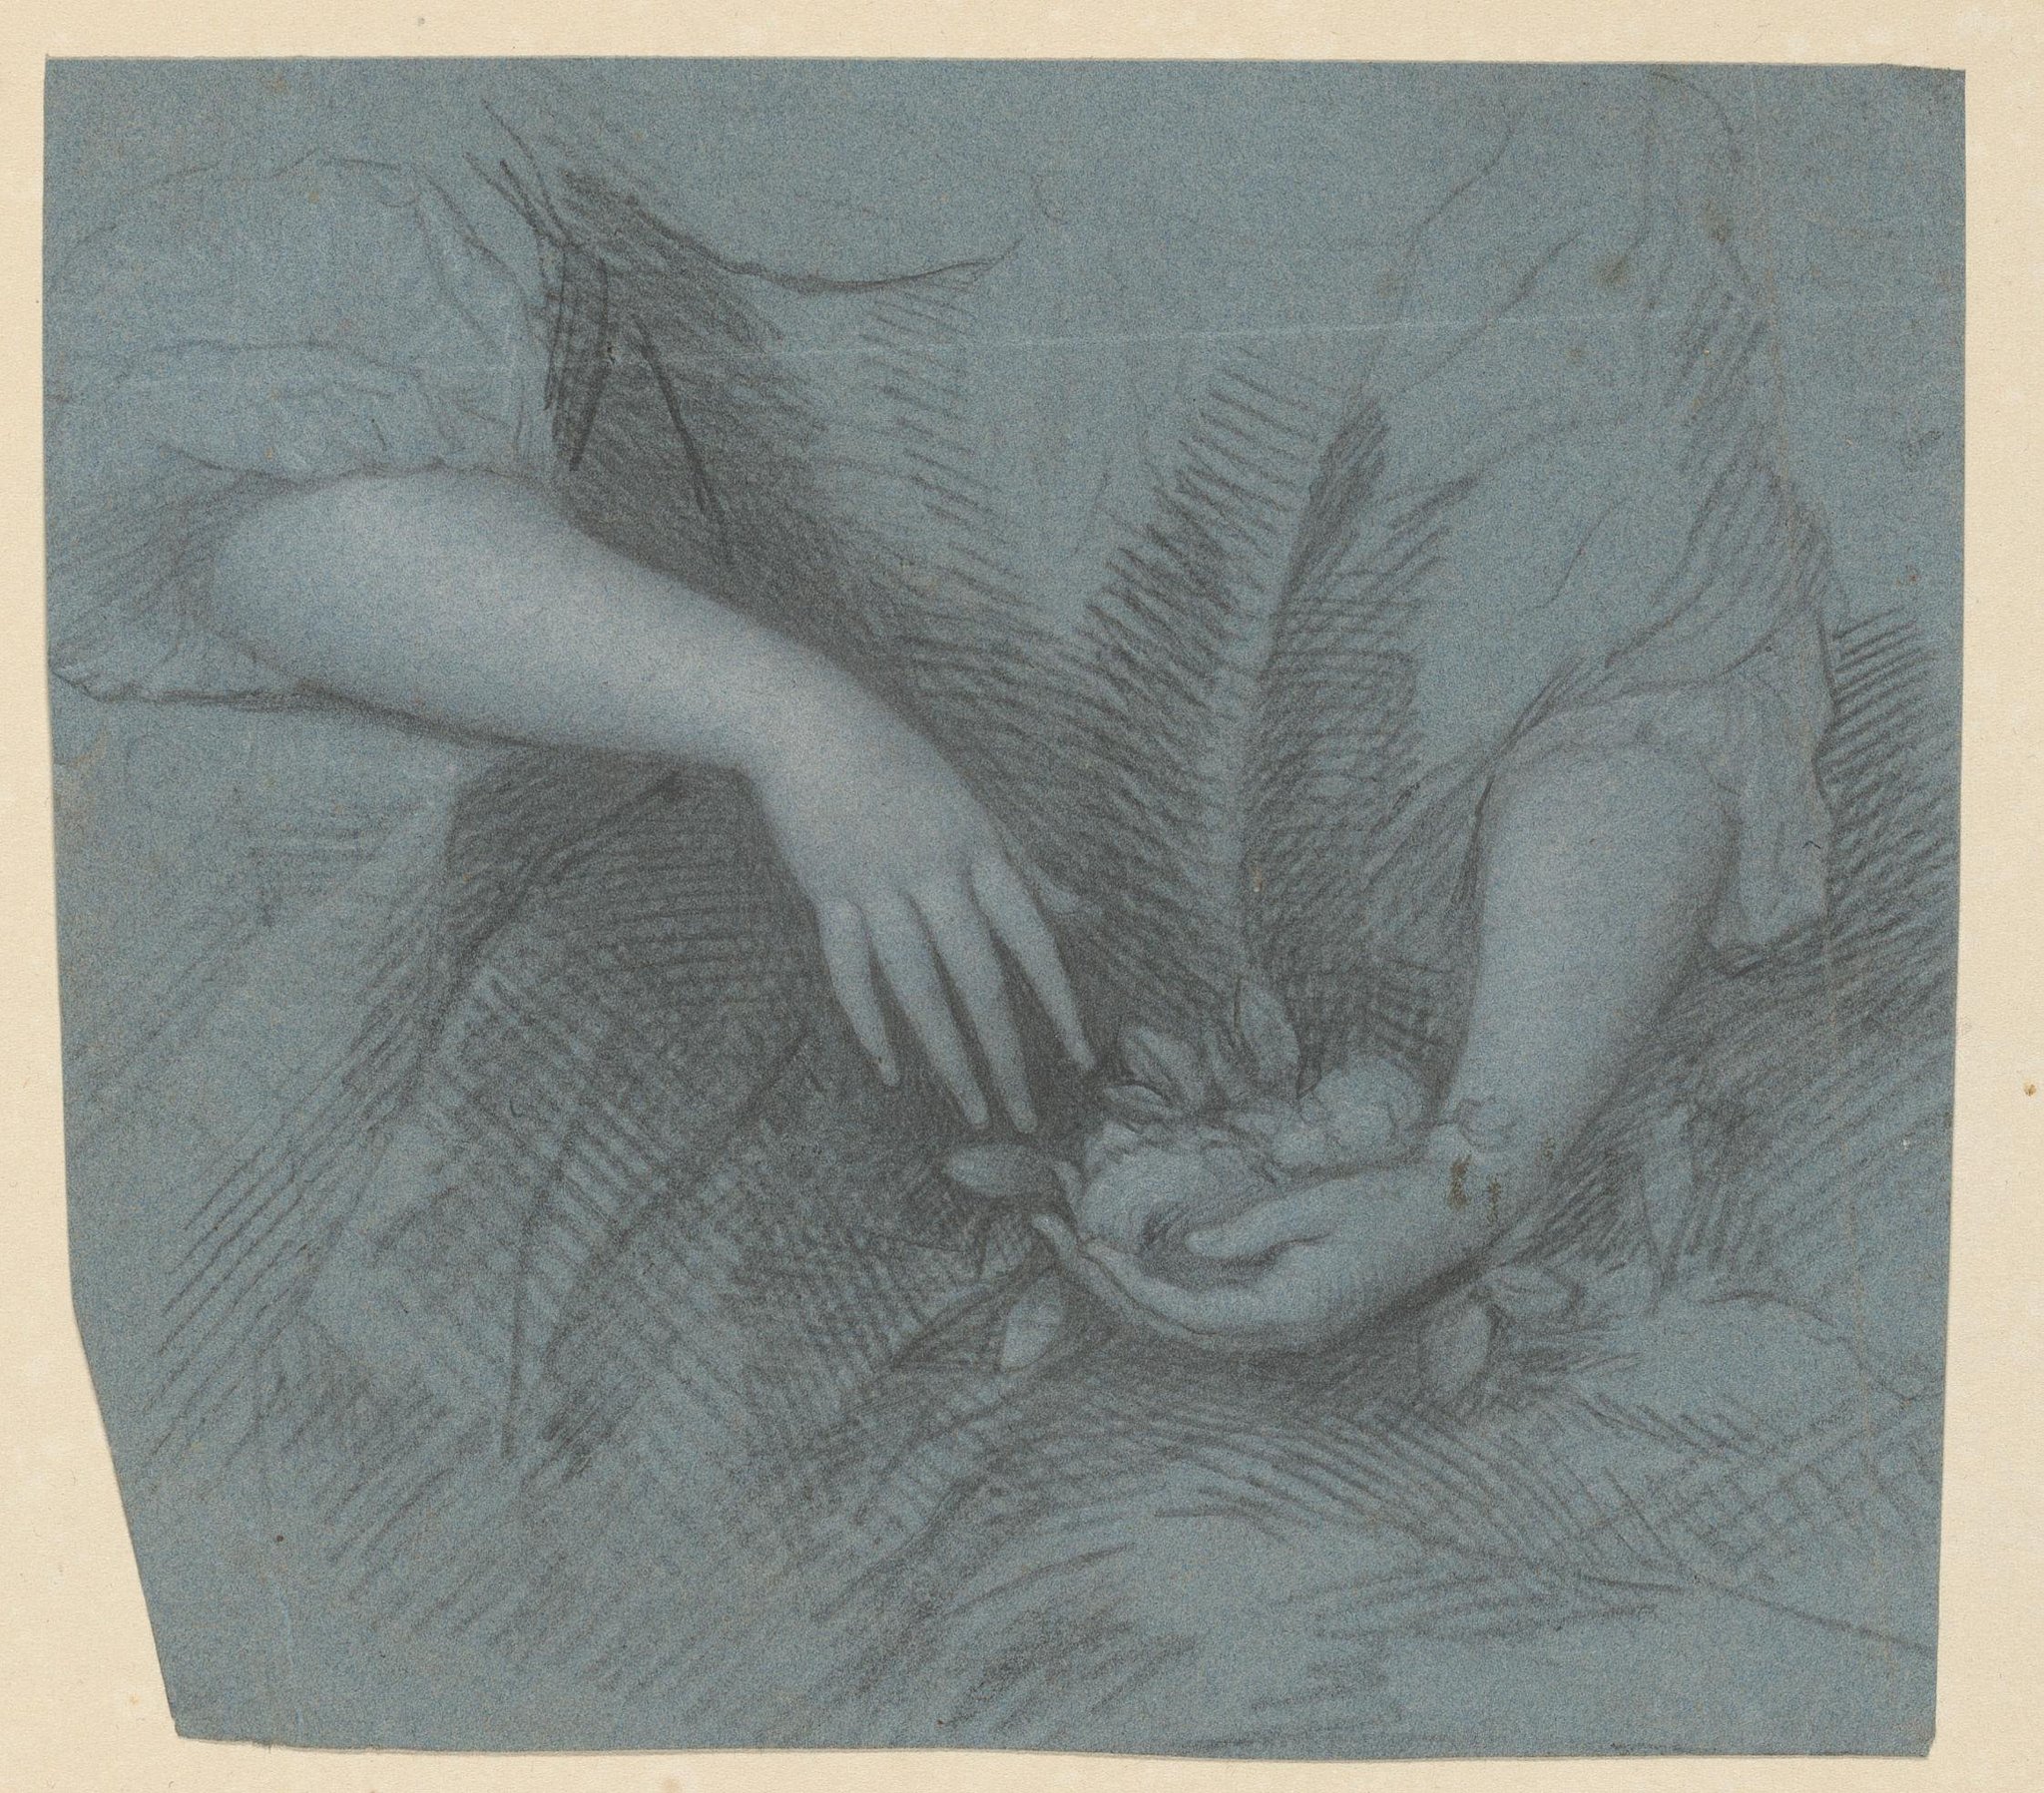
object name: drawing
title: Studie van handen in een schoot, met in de linkerhand bloemen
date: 1649-1723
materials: chalk, paper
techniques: pasting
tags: flowers, lower arm, postures and gestures of arms and hands